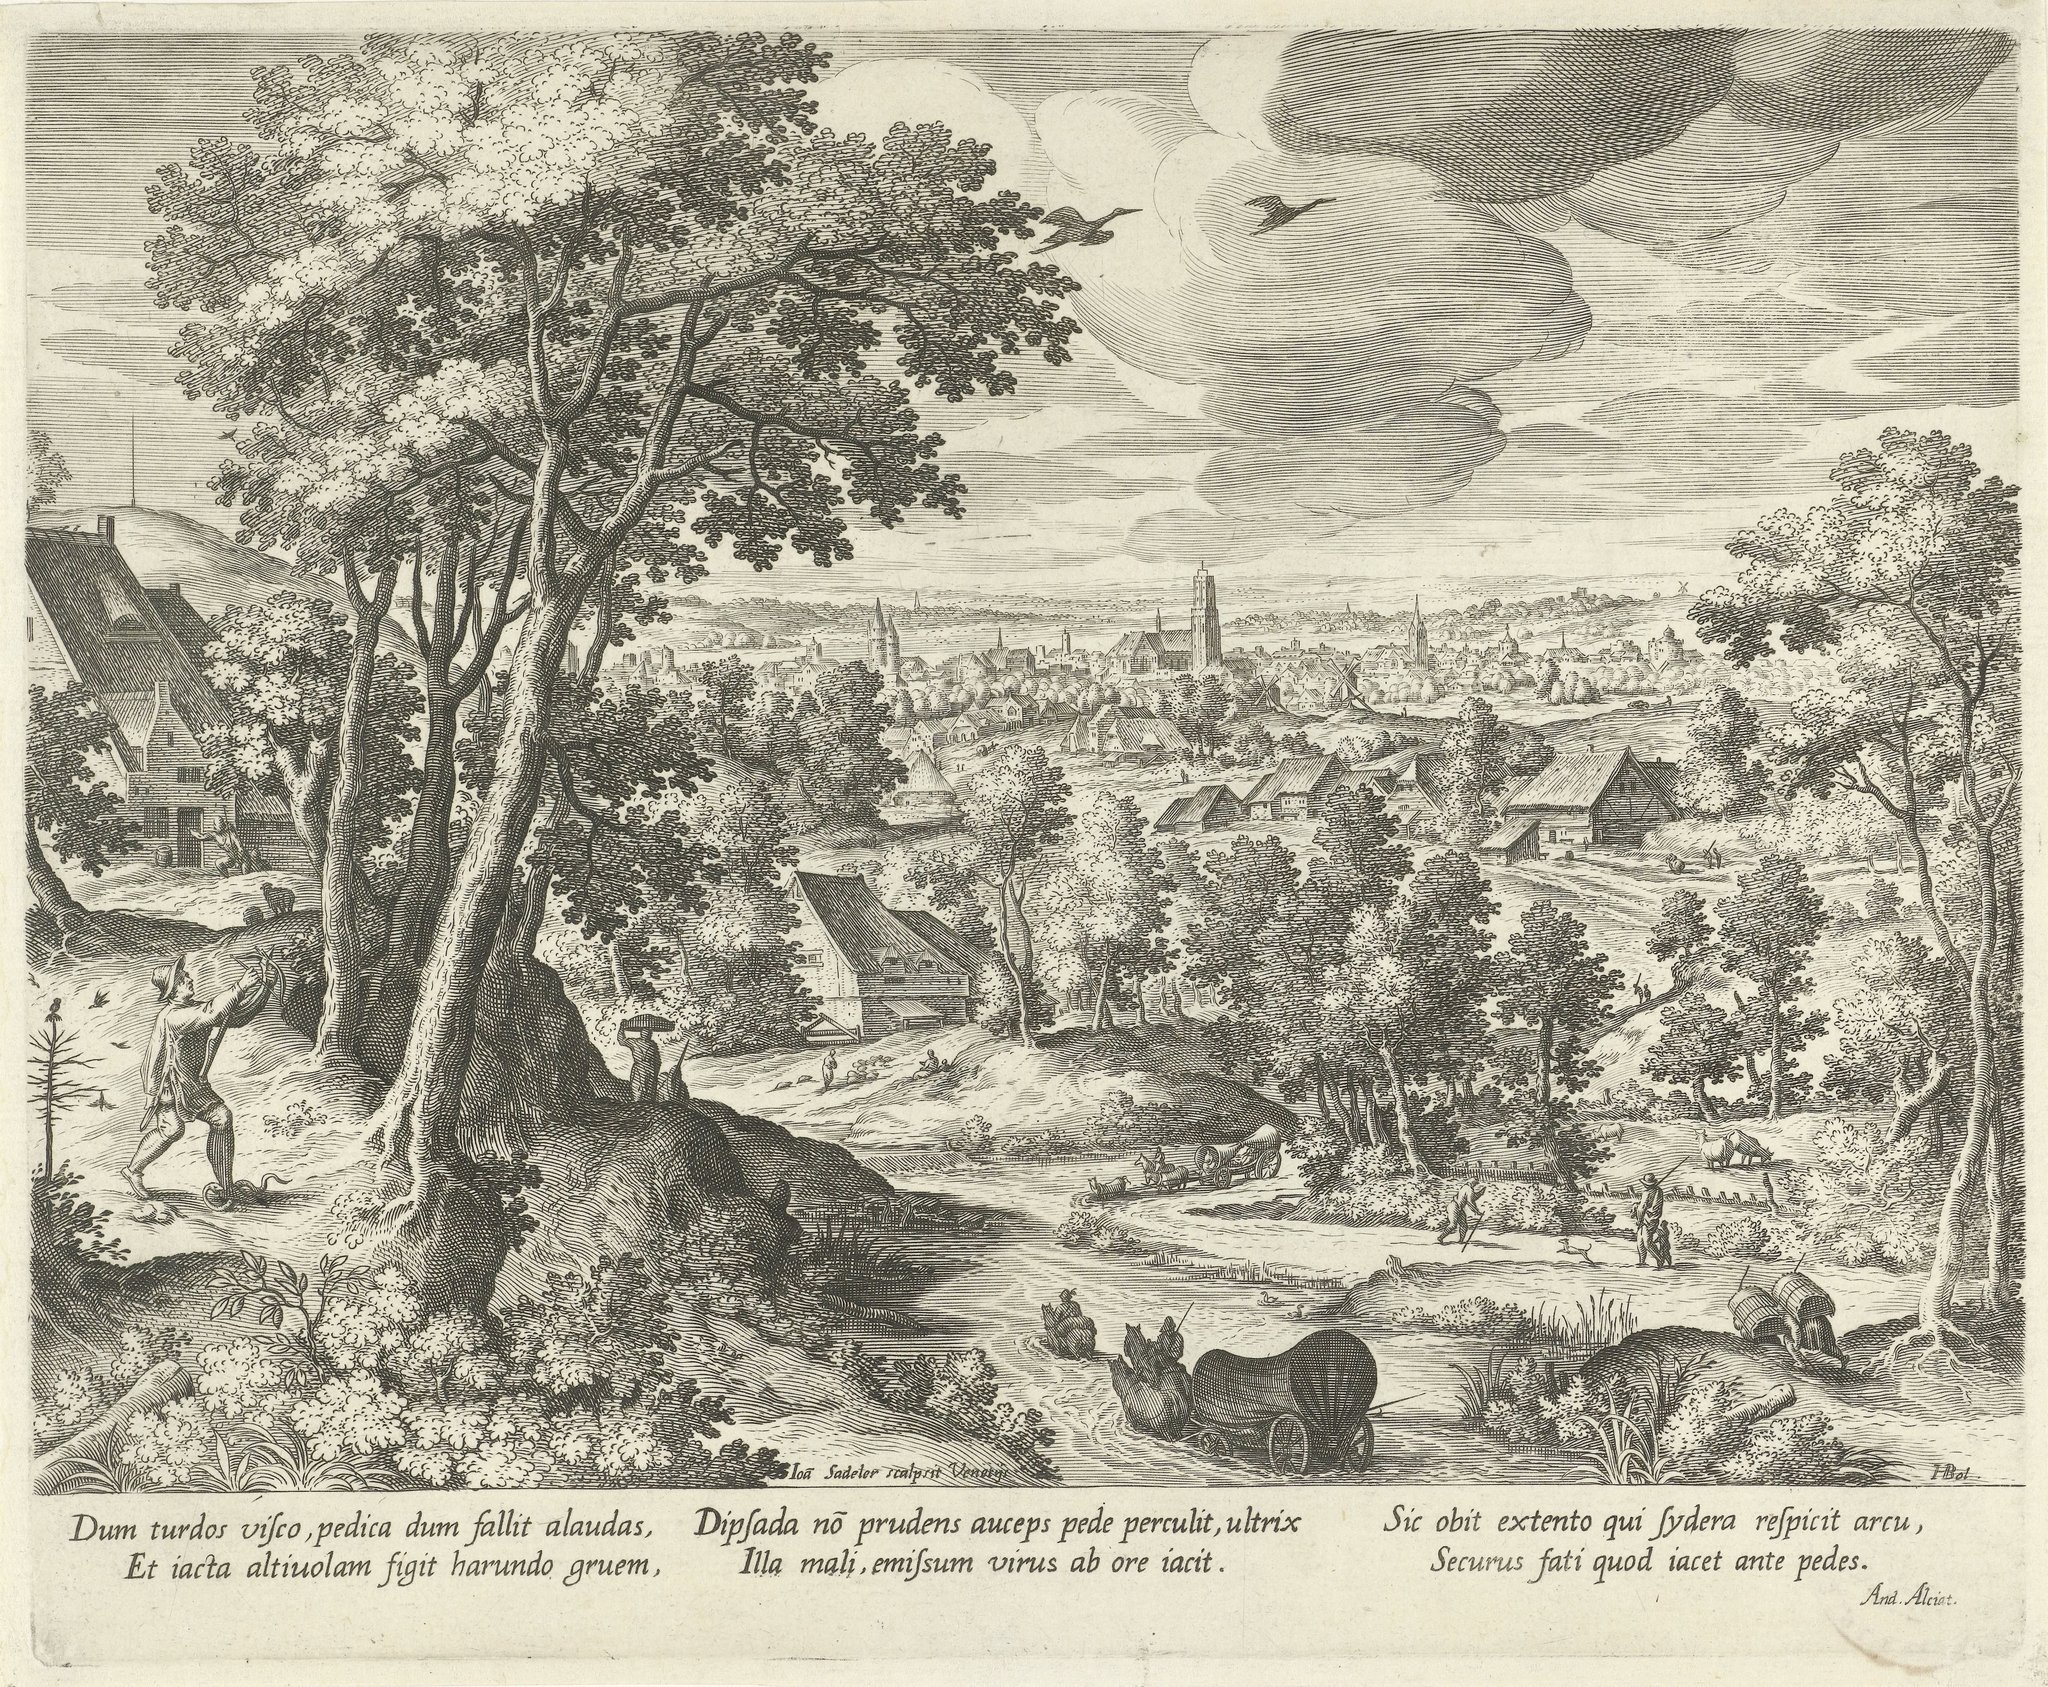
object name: print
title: Landschap met de fabel van de vogelvanger en de slang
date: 1595-1600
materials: paper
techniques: engraving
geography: venice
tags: violent death by snake-bite, rashness, imprudence, recklessness (+ emblematical representation of concept), snakes, river, bird hunting, fowling, fowler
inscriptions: collector's mark: Lugt 240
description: Heuvelachtig landschap met boerderijen. Rechts een huifkar die door de rivier waadt. Links op de voorgrond probeert een jager een vogel neer te schieten. Hij wordt echter door een slang in zijn voet gebeten. Dit is de verbeelding van een embleem waarbij het moraal van het verhaal leert dat hoogmoed voor de val komt. De prent heeft een Latijns onderschrift met het bijschrift van het embleem Qui Alta Contemplantur Cadere van Andrea Alciati.